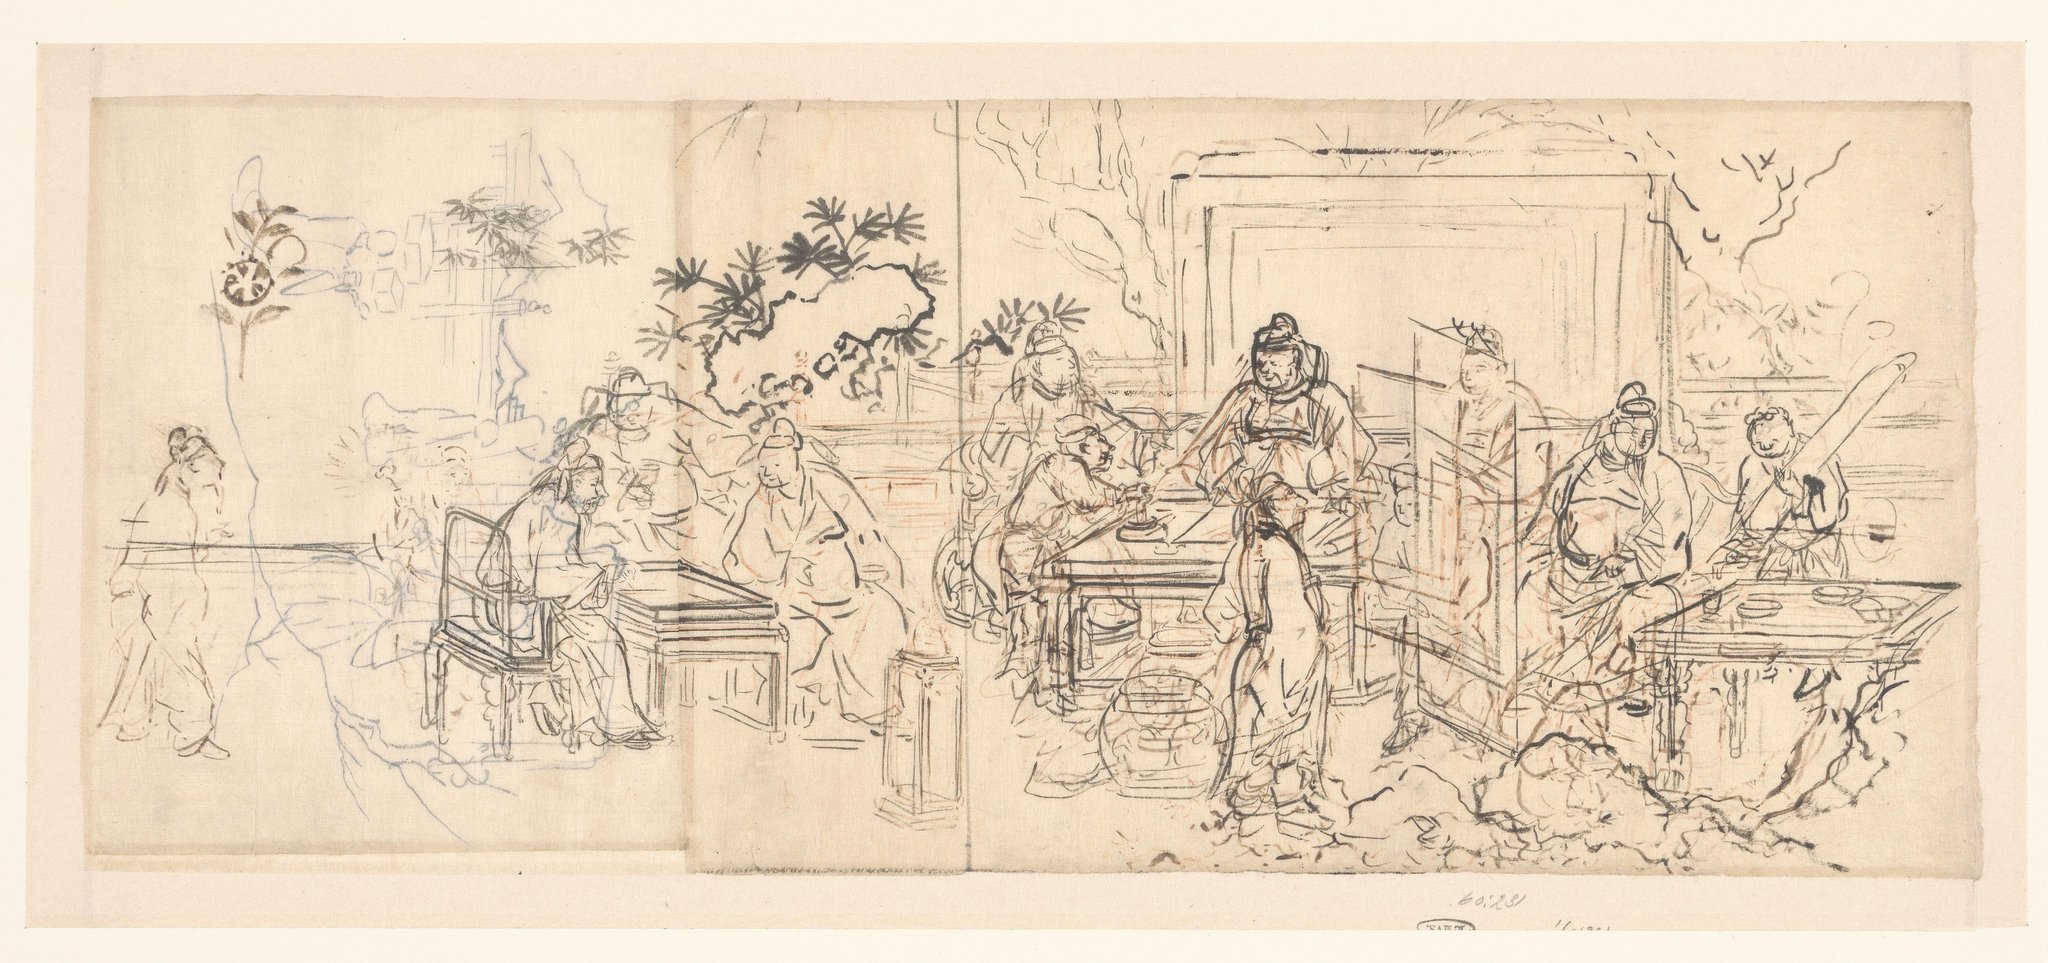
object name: drawing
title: Geleerden in gesprek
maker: utagawa kuniyoshi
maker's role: draughtsman, print maker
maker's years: 1798-1861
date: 1808-1861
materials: ink, paper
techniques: brush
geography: japan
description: Geleerden met in elkaar in gesprek ineen westerse tuin.